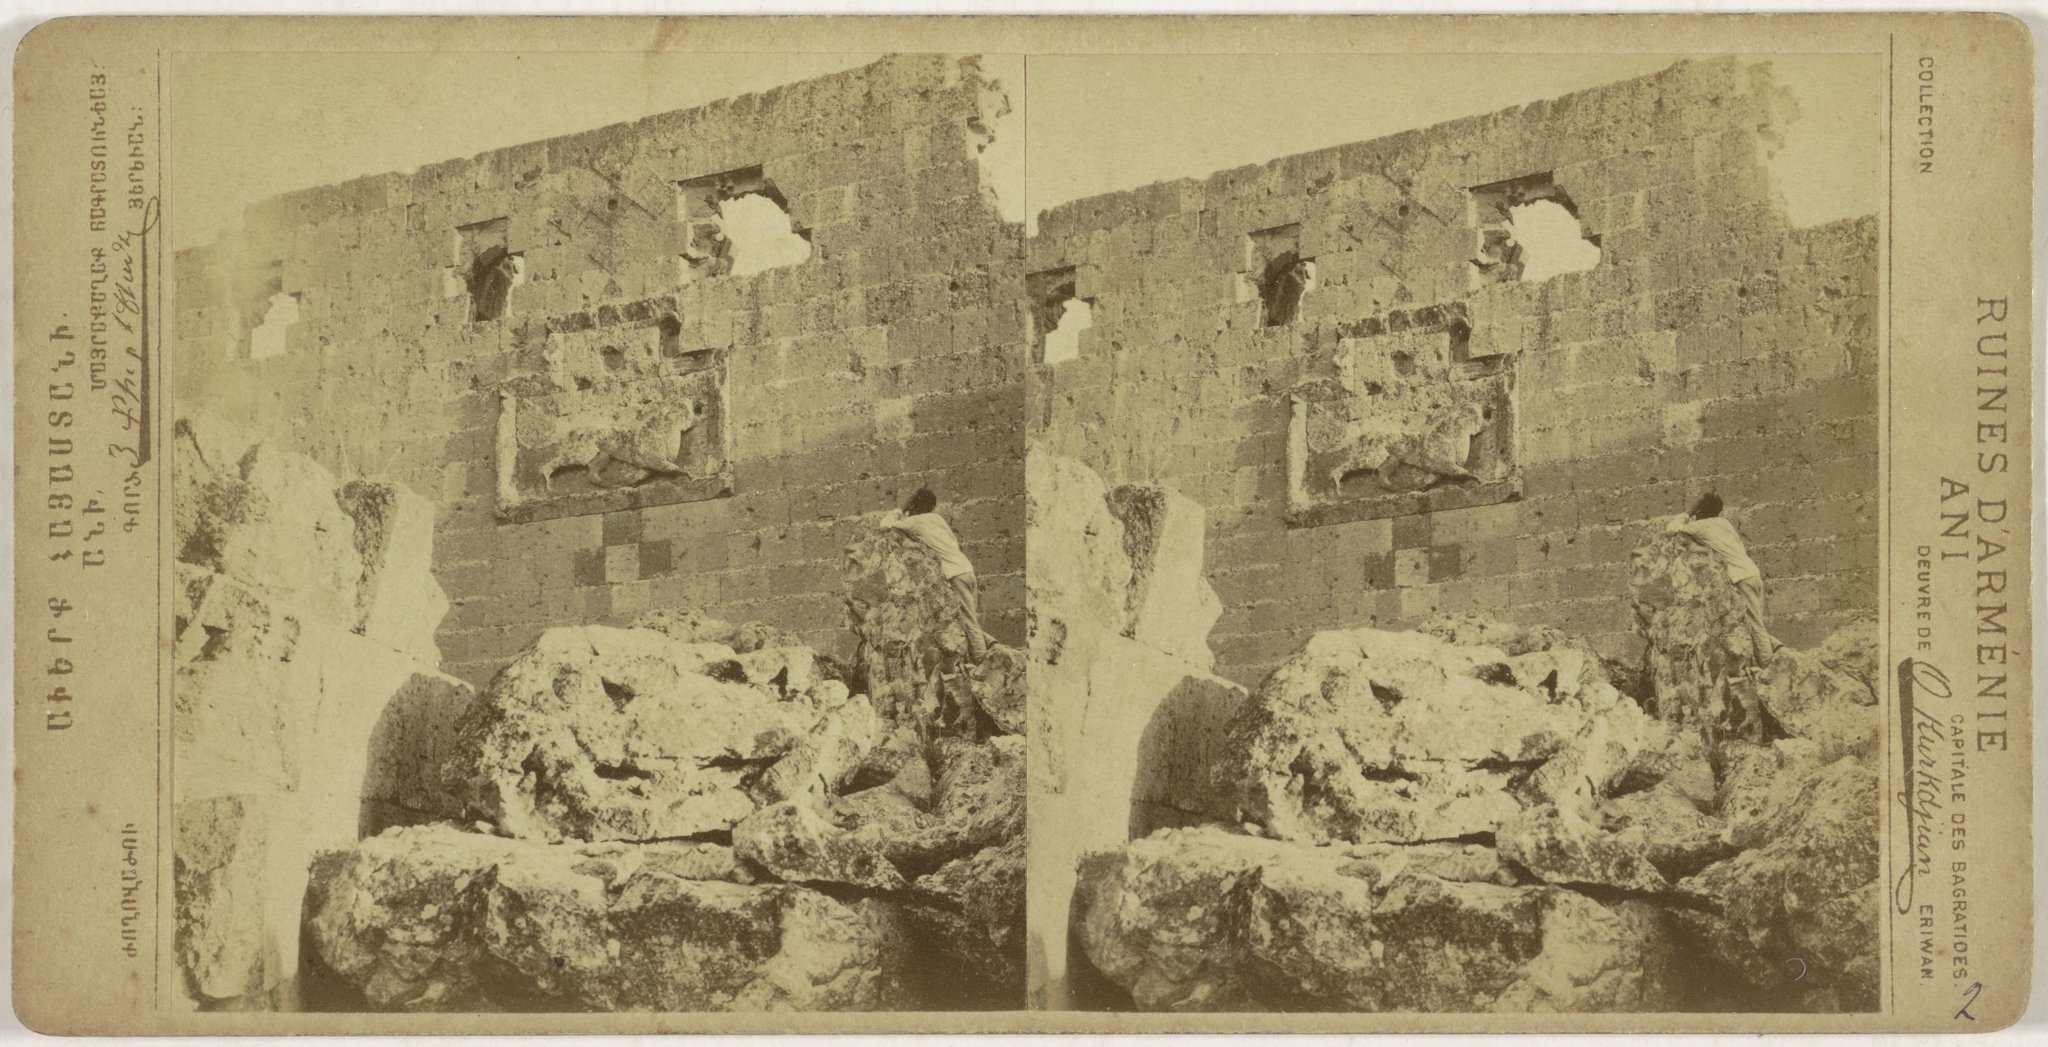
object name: stereograph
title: Ruines d'Arménie. Ani Capitale des Bagratides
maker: onnes kurkdjian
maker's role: fotograaf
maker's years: 1851-1903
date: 1875-1880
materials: cardboard, paper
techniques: albumen print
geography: vienna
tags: ruin of a building ~ architecture, rock-formations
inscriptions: number: ‘2’, inscription: ‘Collection Oeuvre de O. Kurkdjian Eriwan’, inscription: ‘Tous droits résérvés.’